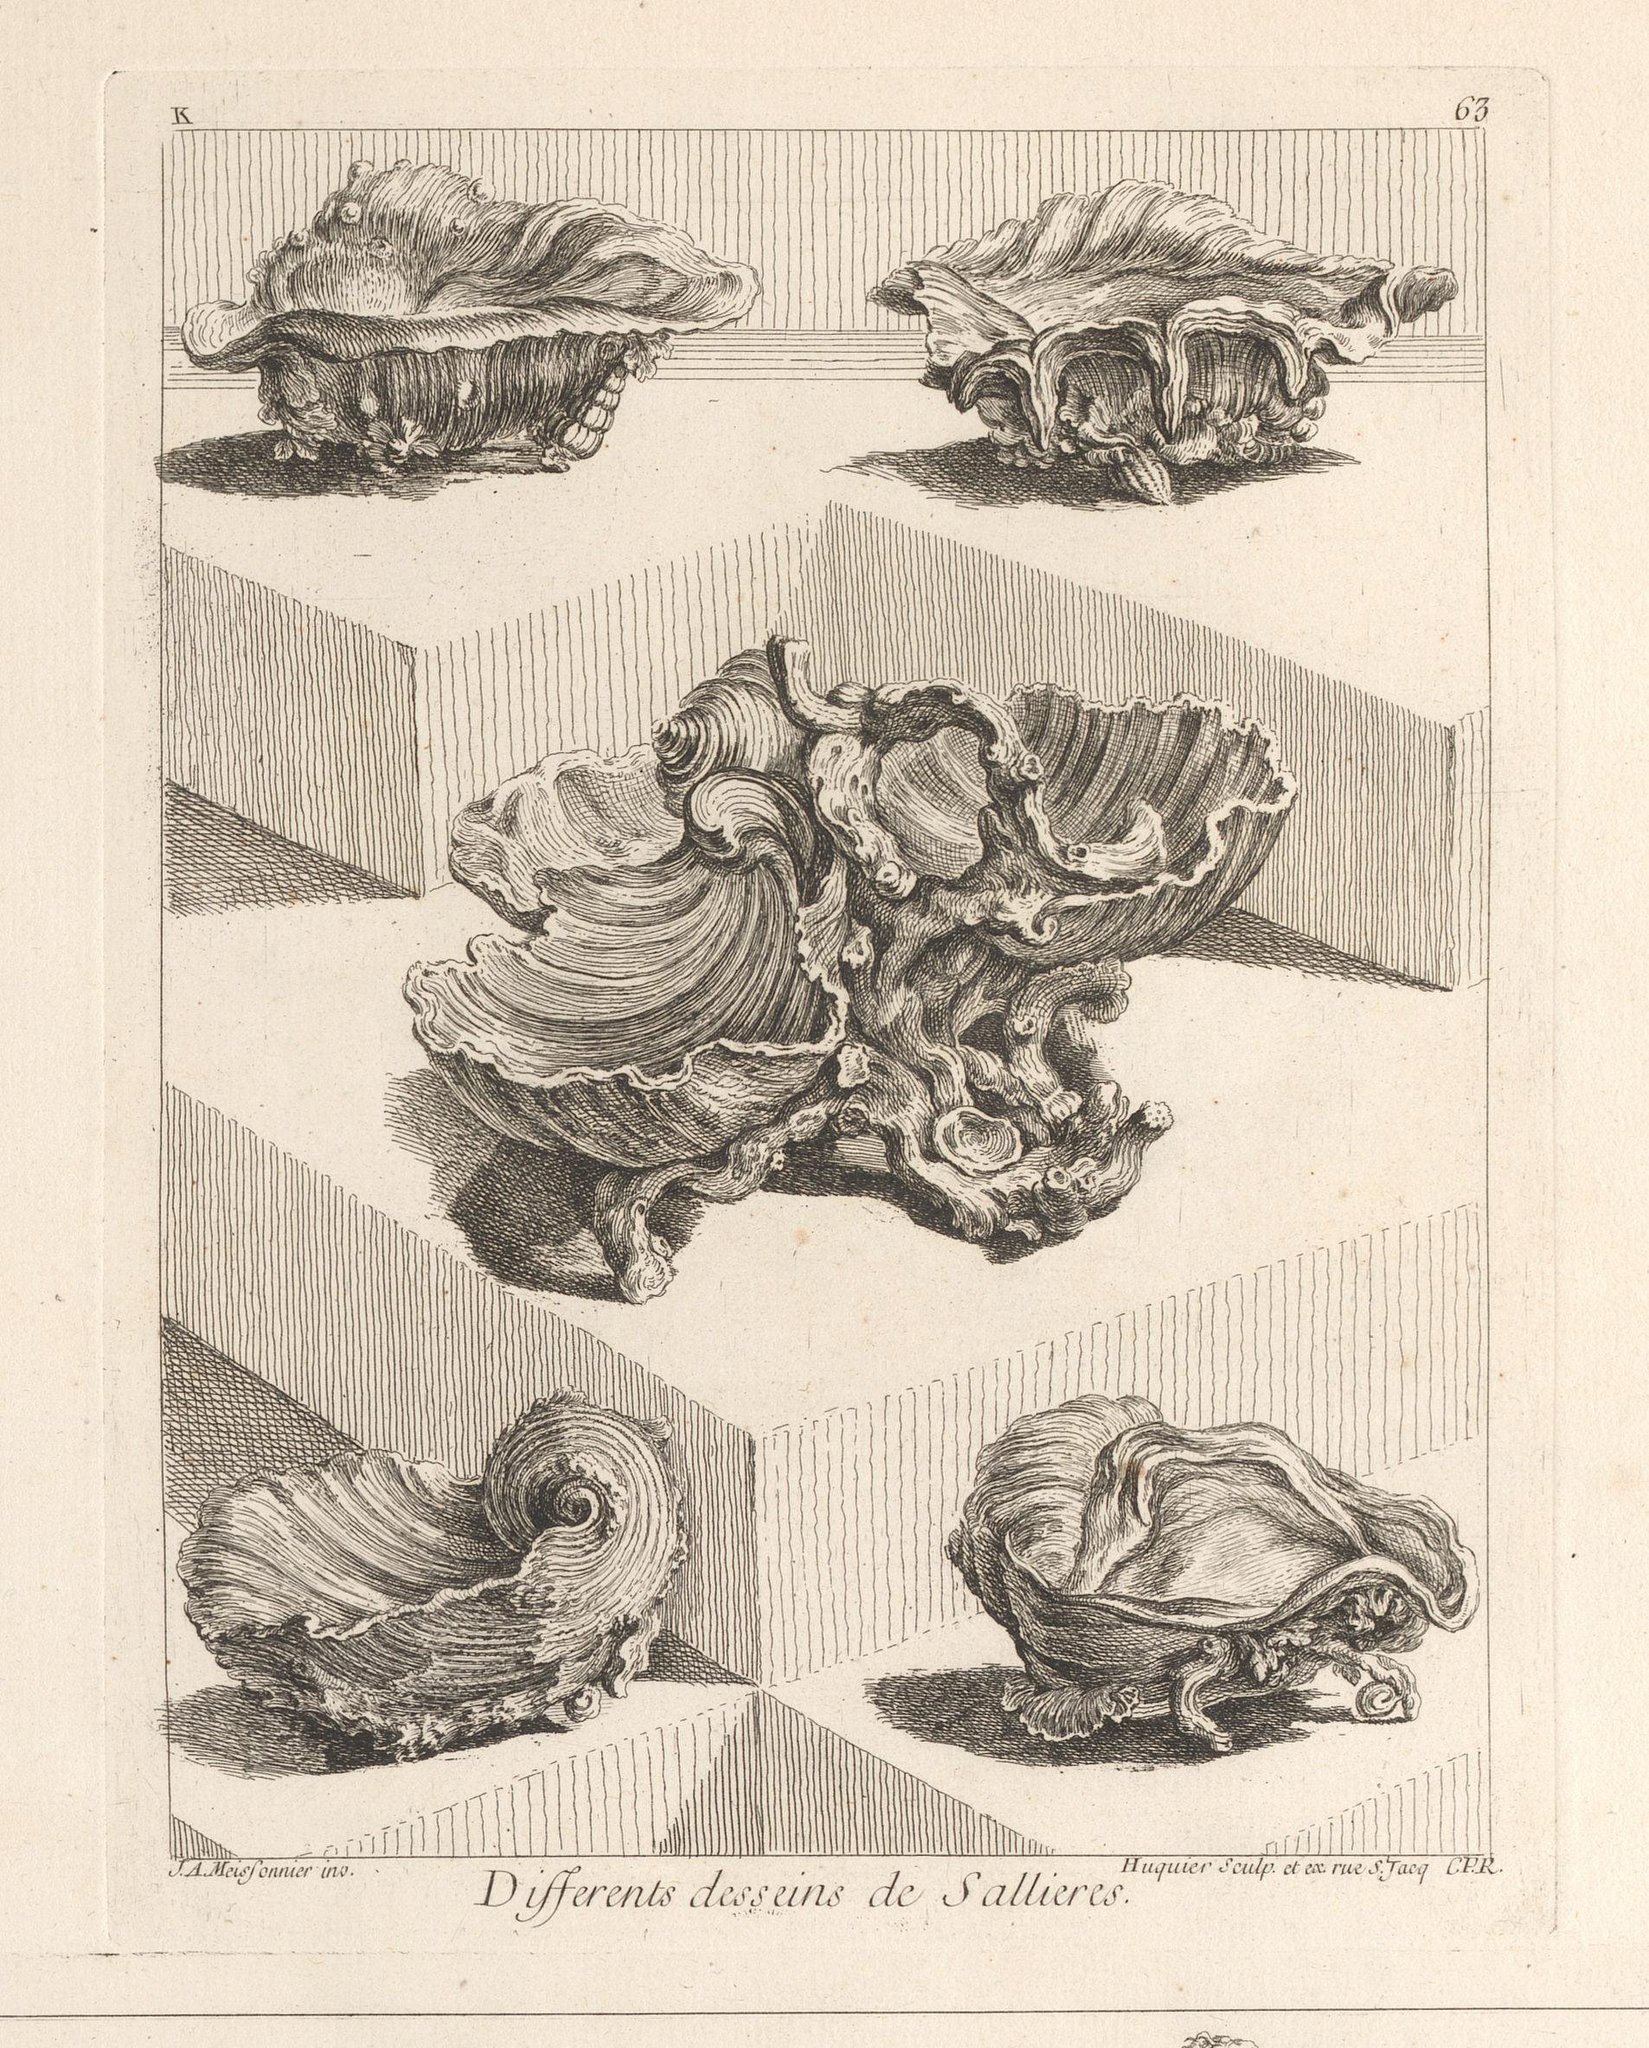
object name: album leaf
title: Oeuvre de Juste Aurele Meissonnier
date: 1738-1749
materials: paper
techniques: etching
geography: paris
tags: work of applied art, salt-cellar, salt-shaker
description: Deze prent maakt deel uit van de serie "Dixieme livre des oeuvres de J.A. Messonnier", een van de delen van de monumentale reeks "Oeuvre de Juste Aurele Meissonnier".